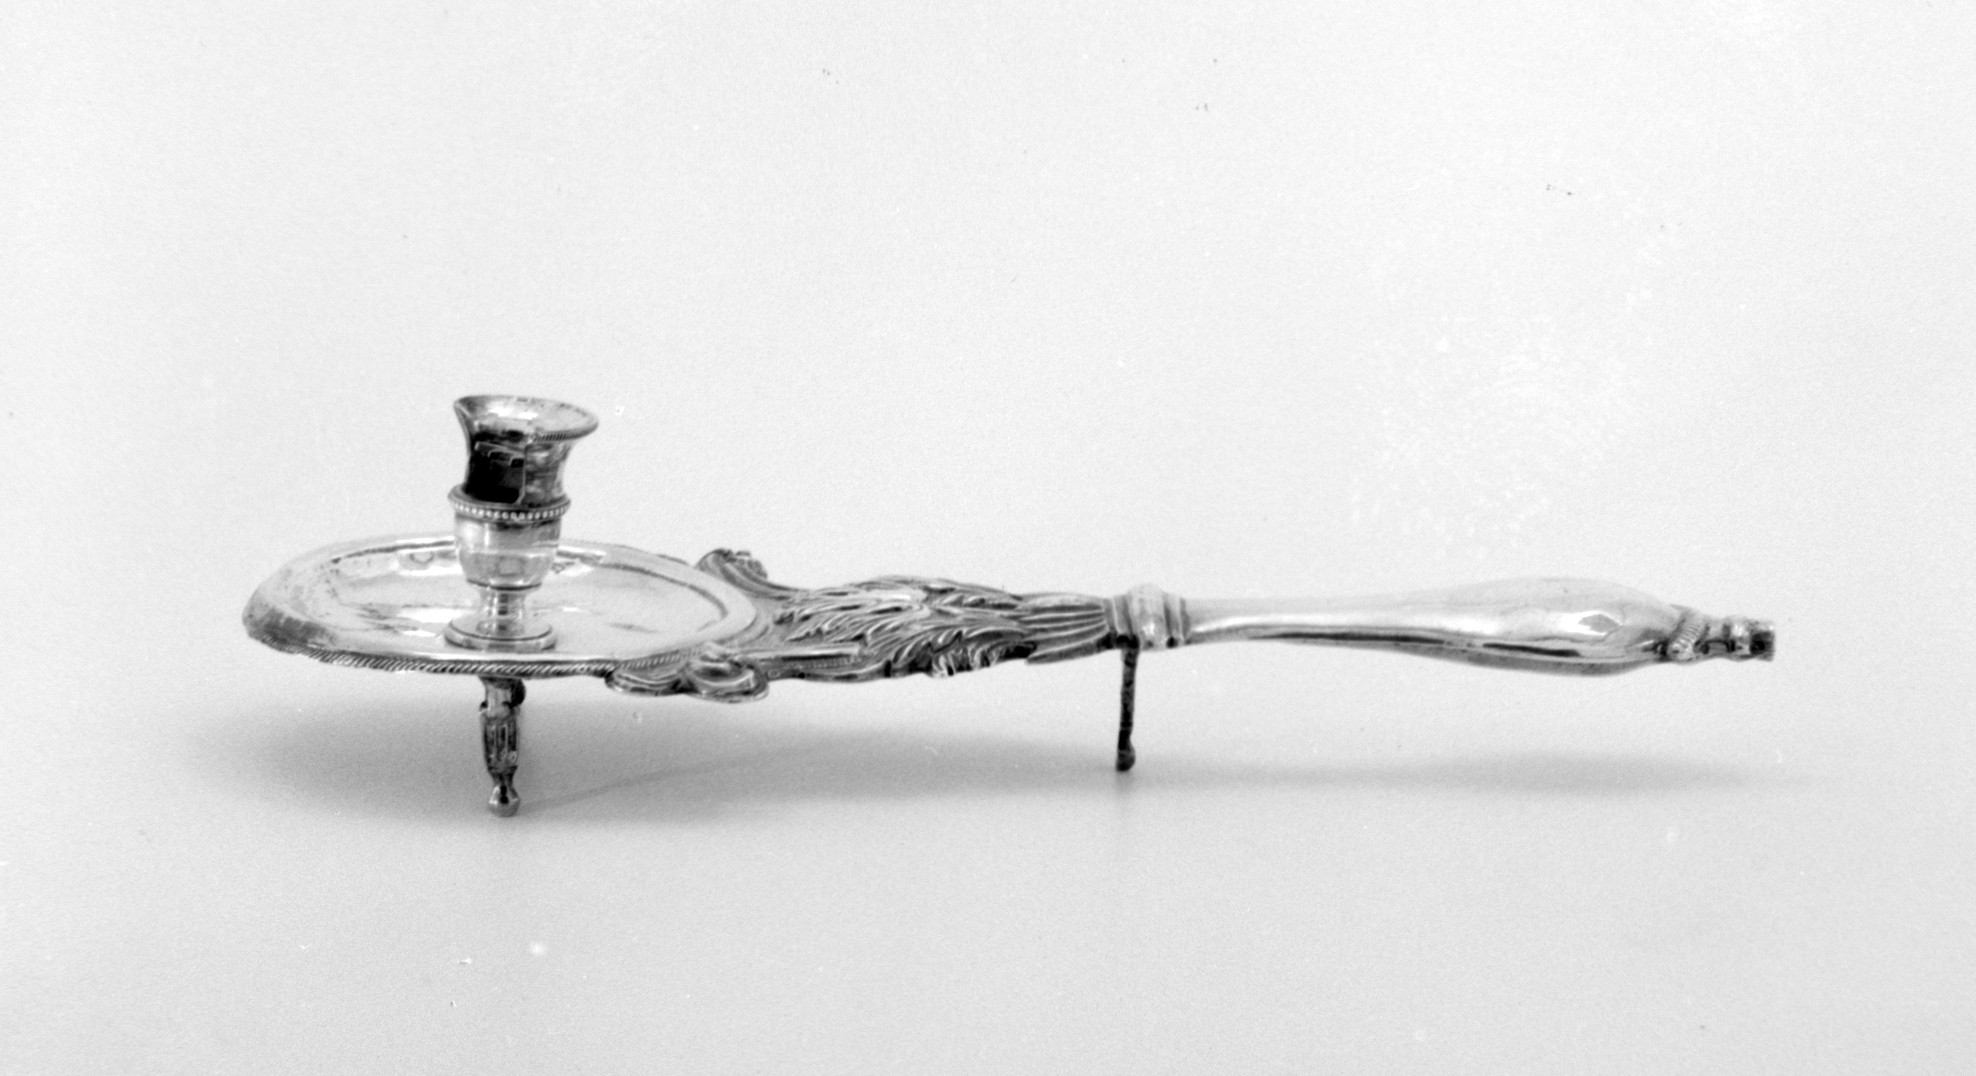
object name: candlestick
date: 1701-1800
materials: silver